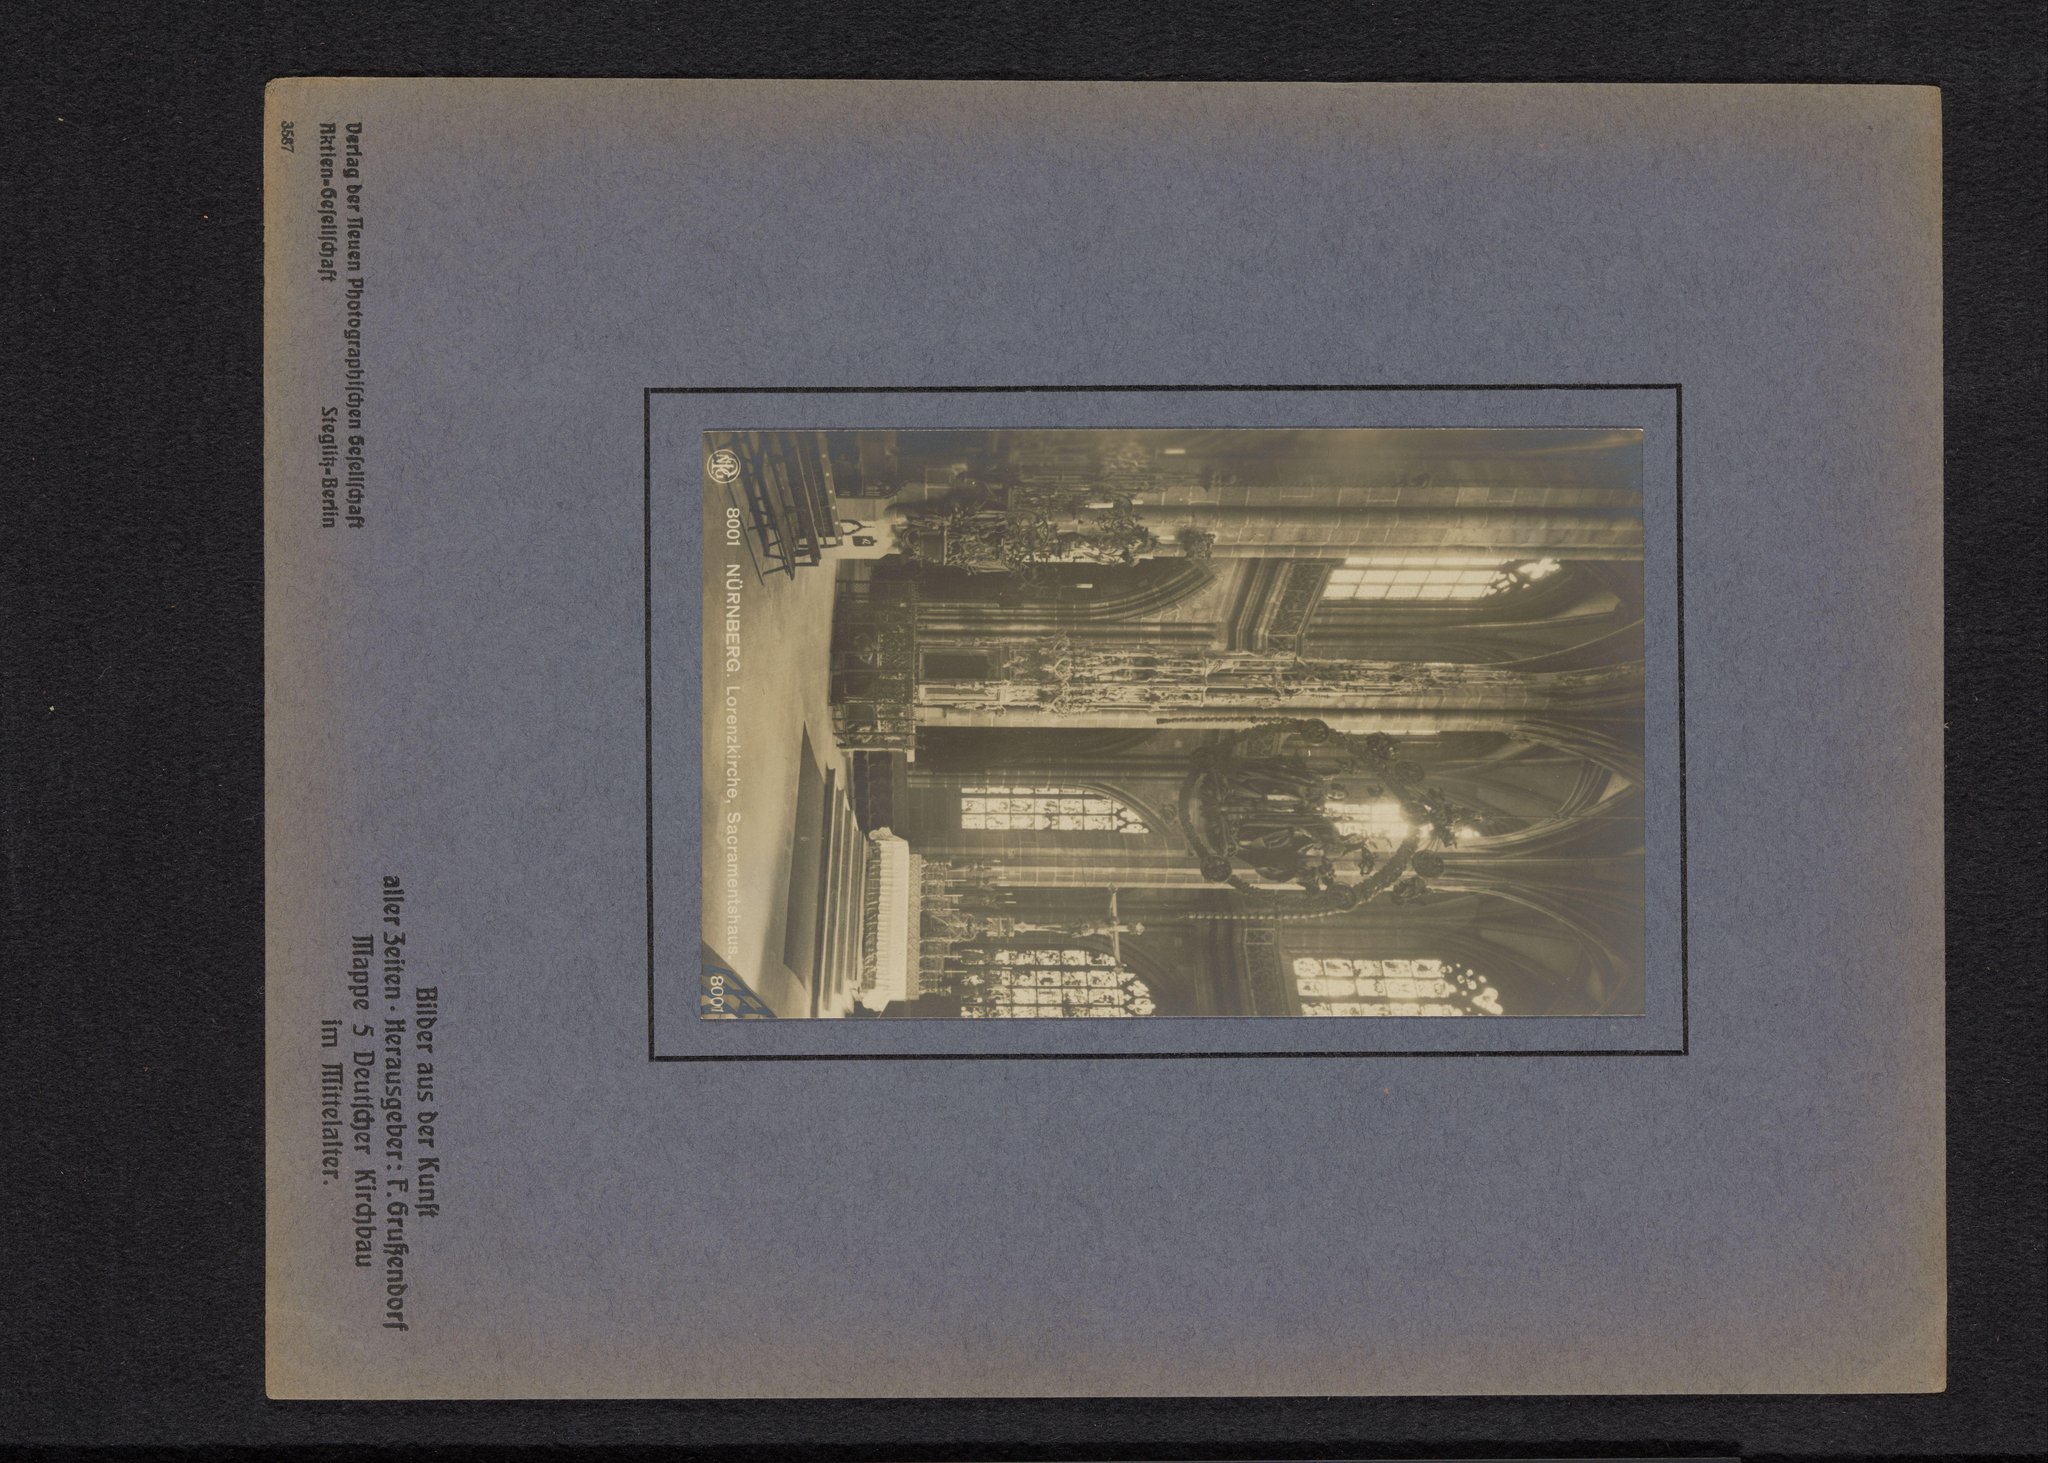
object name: photograph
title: Interieur van de Sint-Laurentiuskerk in Neurenberg met zicht op het sacramenthuis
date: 1900-1911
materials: cardboard, photographic support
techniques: gelatin silver print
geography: nuremberg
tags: sacrament-house, interior of church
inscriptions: number: ‘8001’, number: ‘3587’